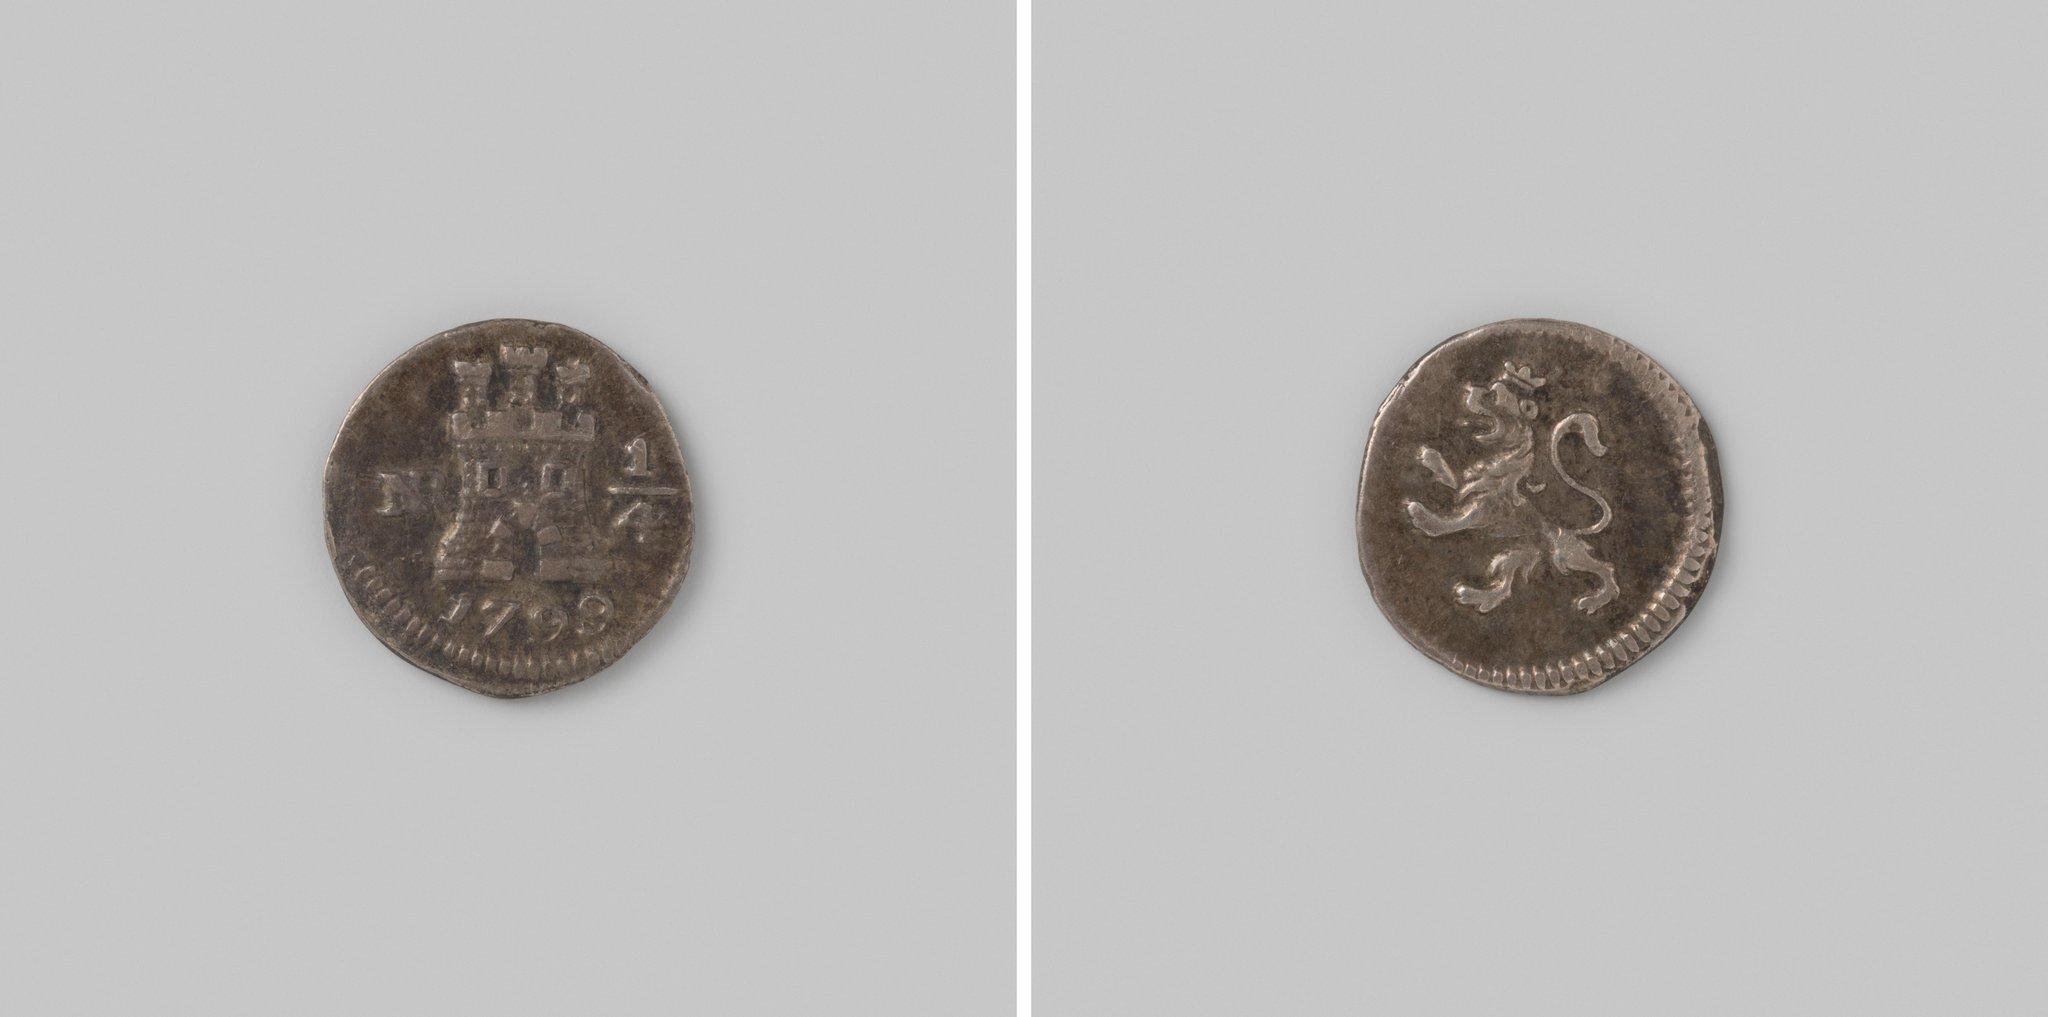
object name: kwart reaal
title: Nicaragua, koning Karel IV,1/4 reaal,1799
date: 1799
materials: silver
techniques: striking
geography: nicaragua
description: Zilveren munt. Voorzijde: tussen muntplaats-aanduiding: N [=Nicaragua] en waarde-aanduiding: 1/4, kasteel. Jaartal onderaan. Keerzijde: gekroonde klimmende leeuw naar links. Gladde rand.